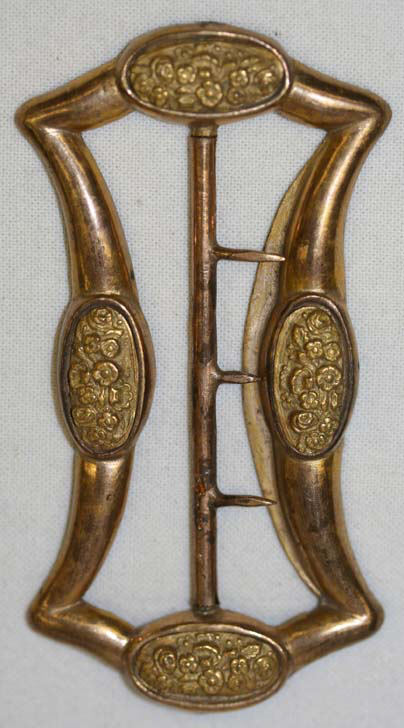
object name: belt buckle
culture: european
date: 1840-1849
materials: gold